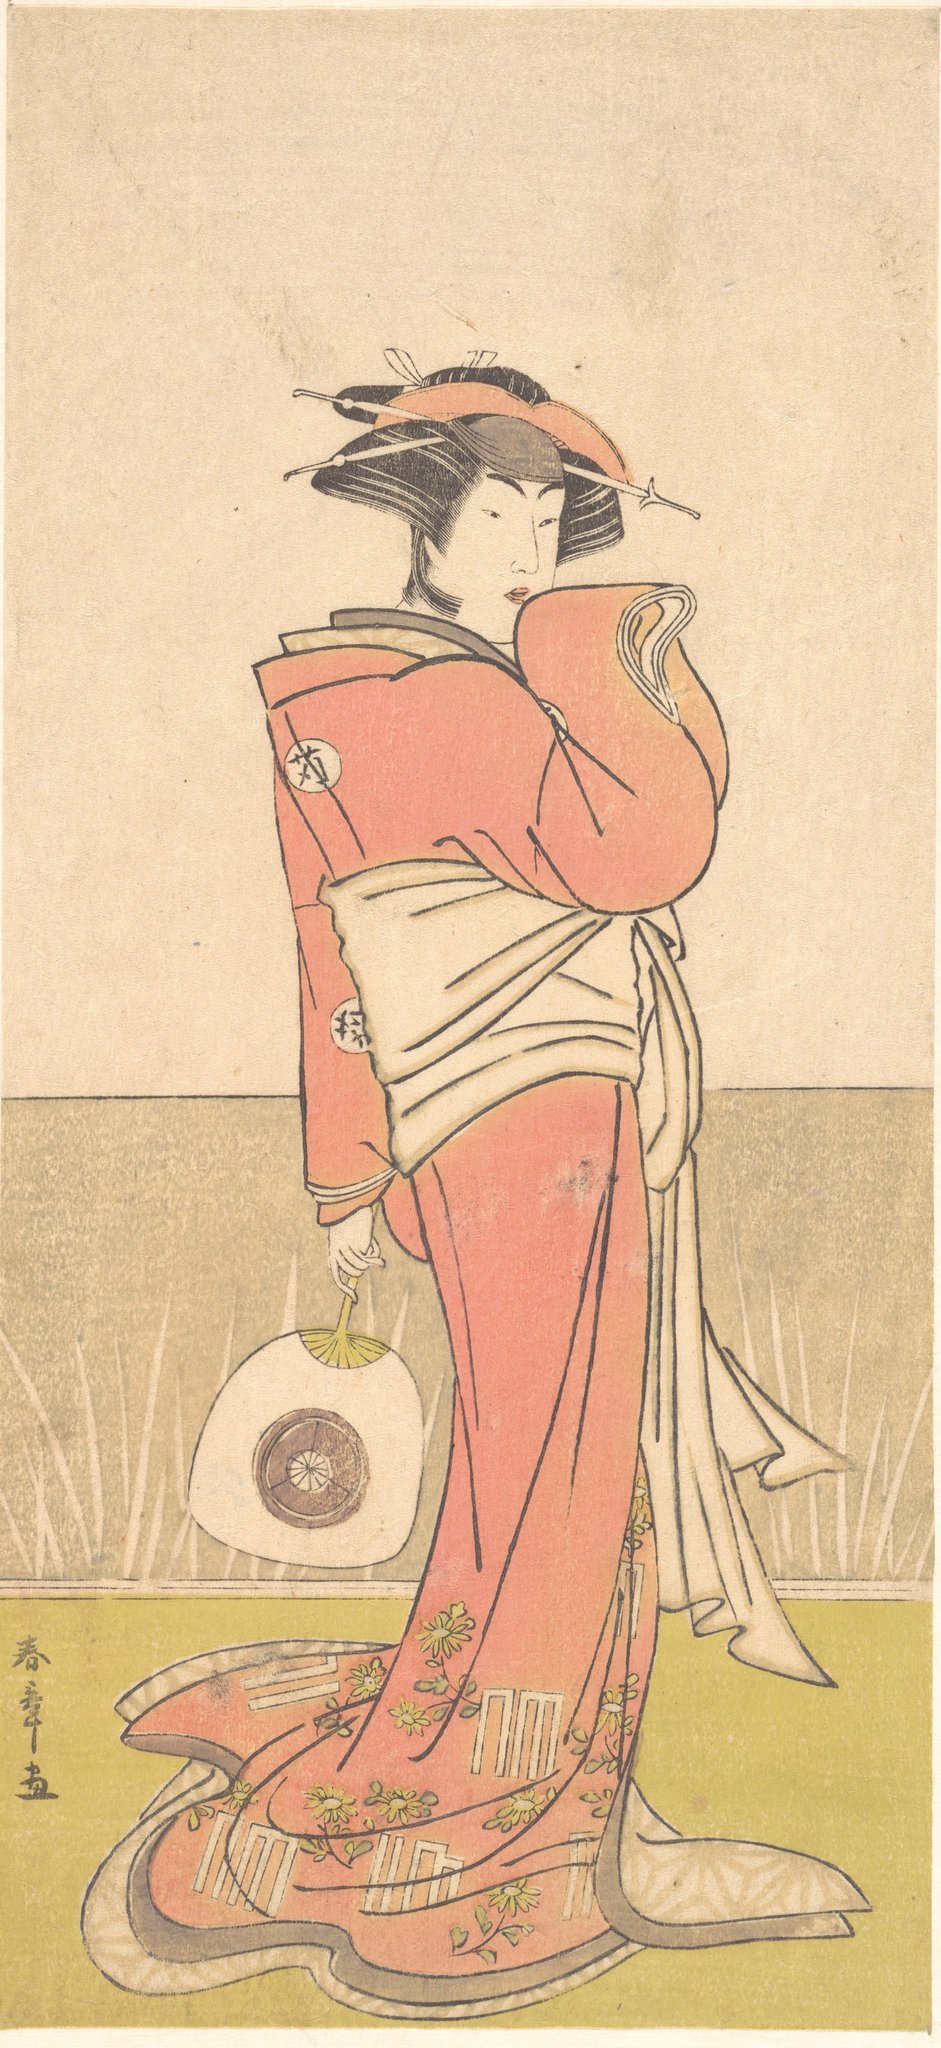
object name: woodblock print nishiki e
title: Iwai Hanshirō IV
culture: japanese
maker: katsukawa shunshō 勝川春章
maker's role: artist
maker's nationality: japanese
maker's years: 1726-1792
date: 1780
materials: ink, paper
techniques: nishiki e, woodblock print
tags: human figures,fans